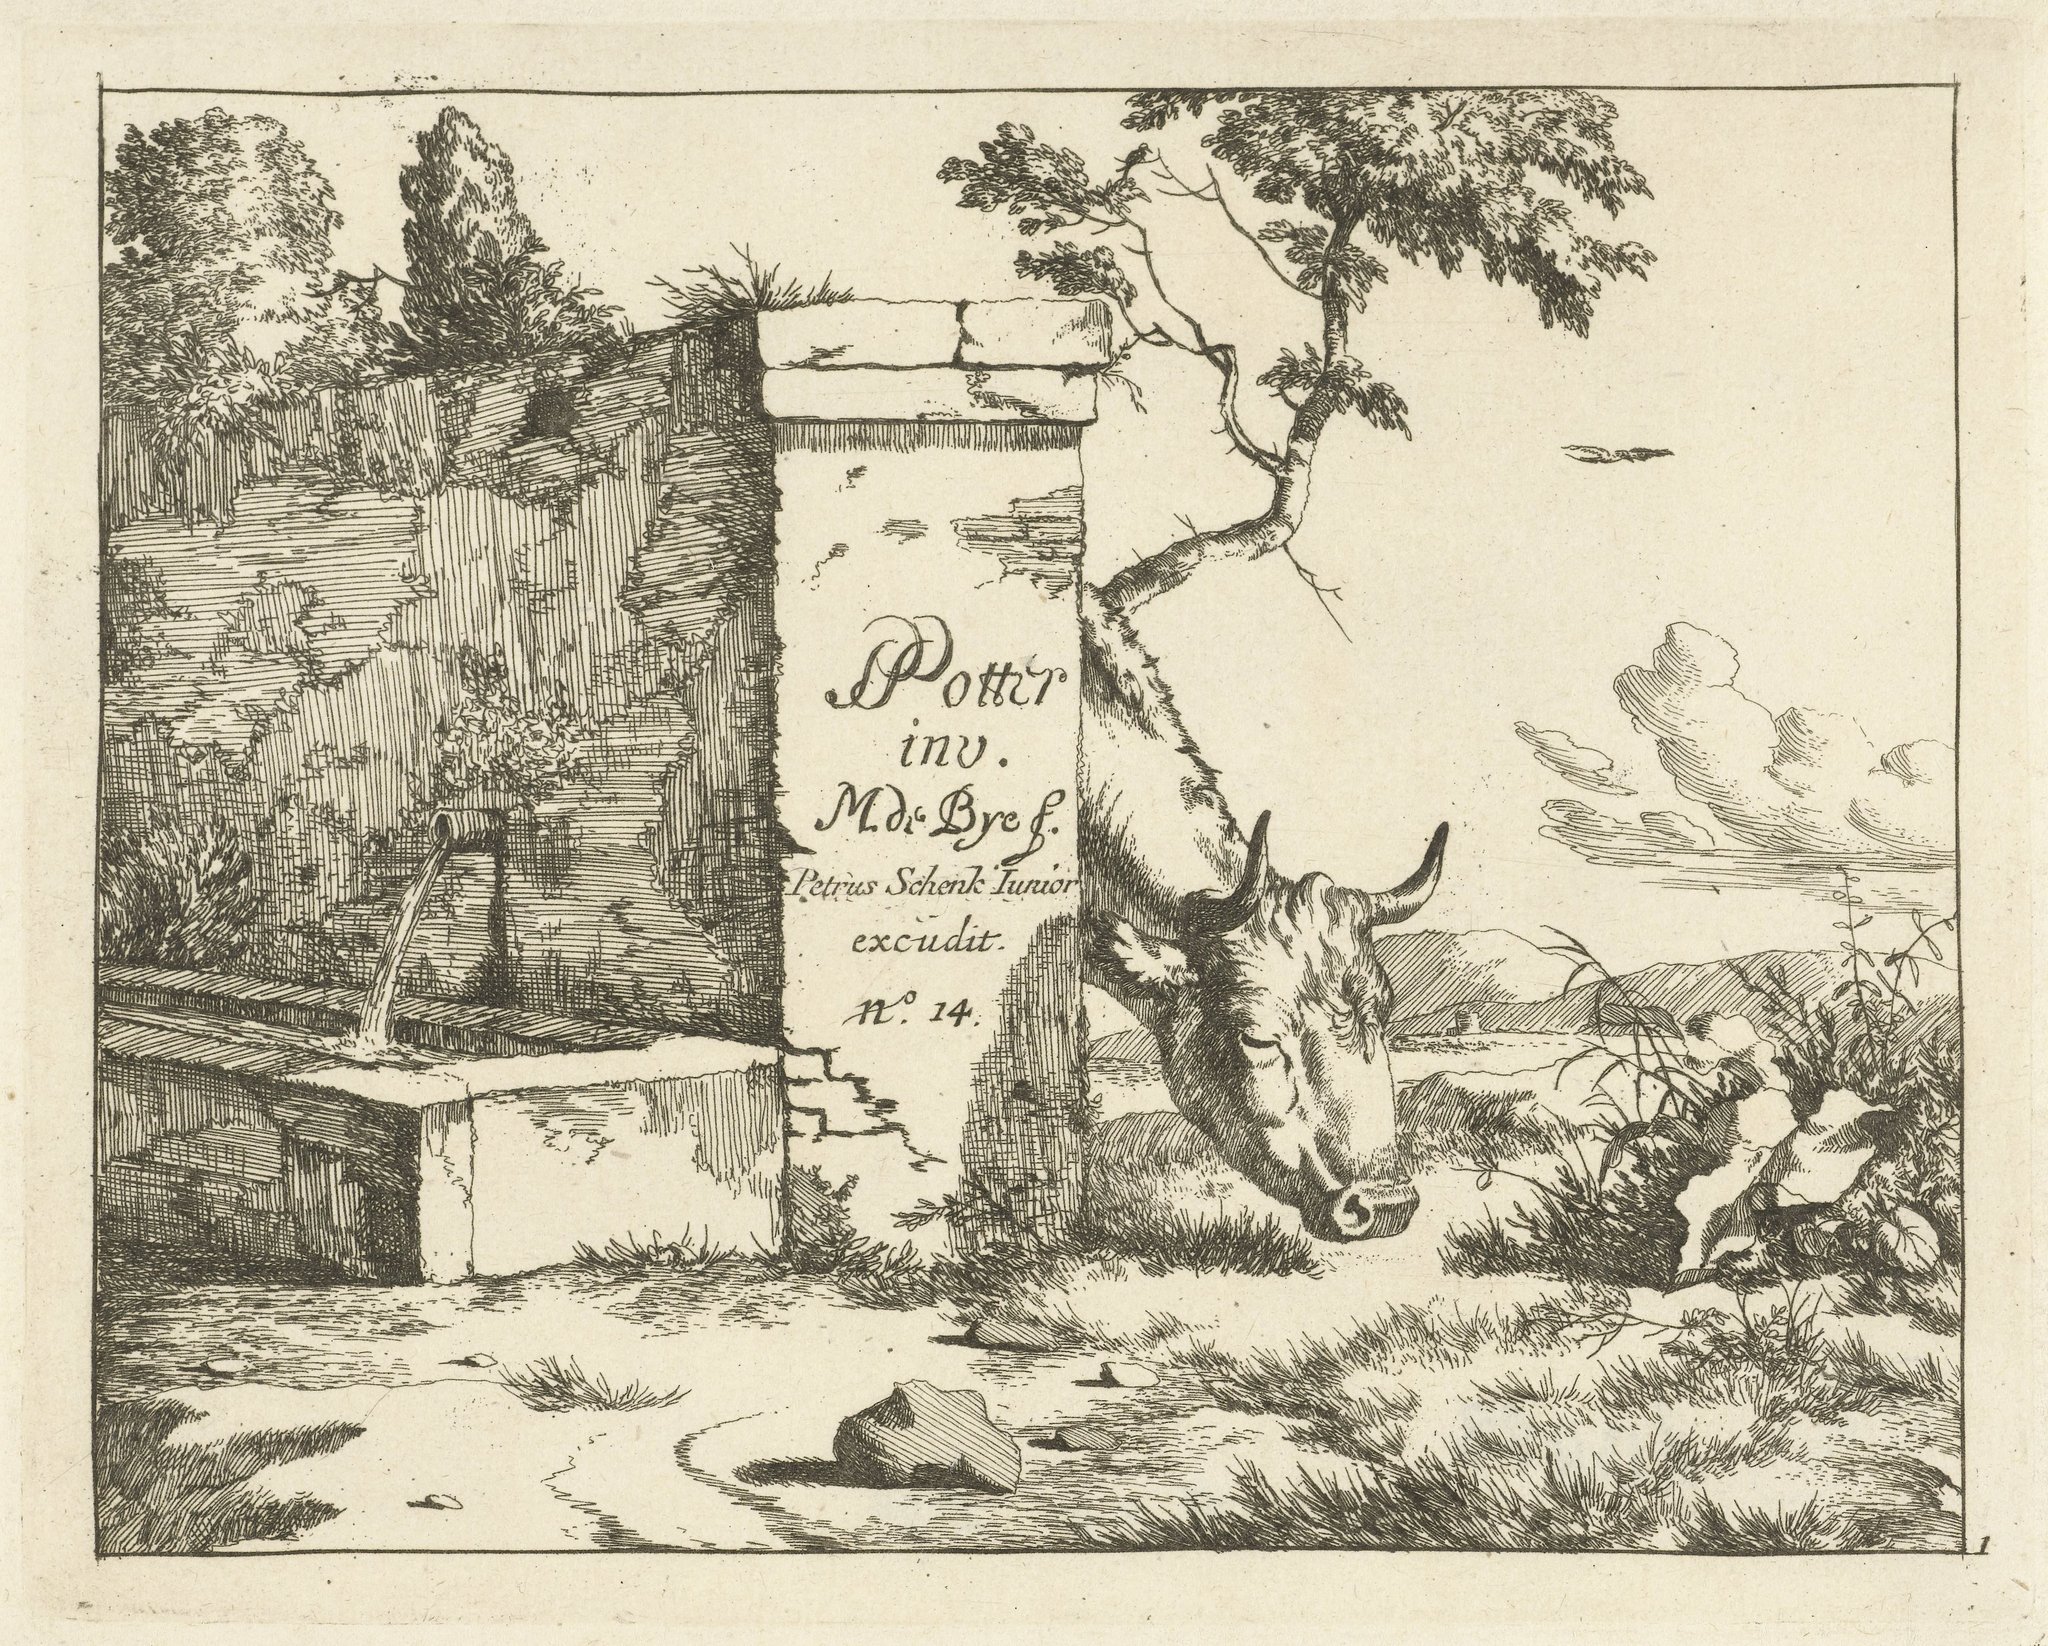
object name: print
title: Grazend rund achter muur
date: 1728-1768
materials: paper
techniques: etching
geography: the hague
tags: cow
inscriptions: collector's mark: Lugt 2228